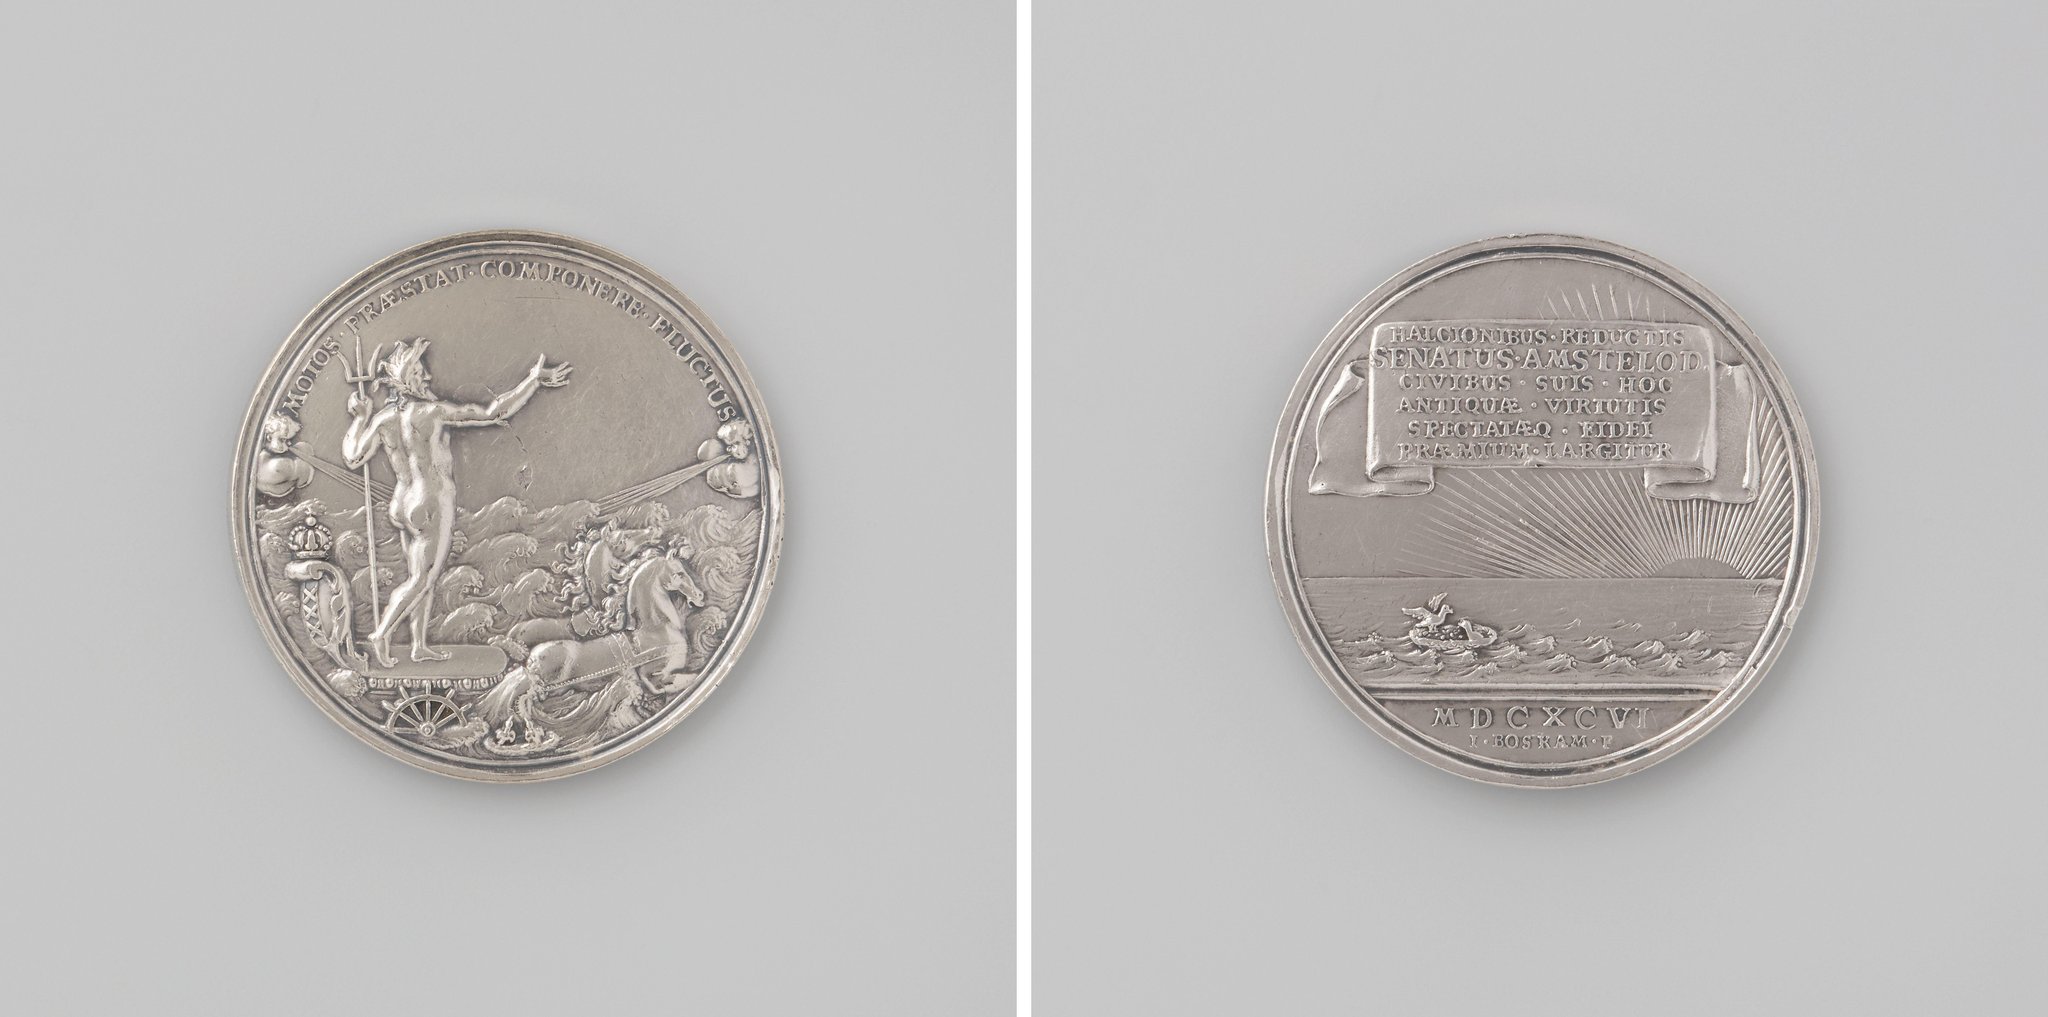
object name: history medal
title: Stillen van het aansprekersoproer te Amsterdam, penning aan de gewapende burgers vereerd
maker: jan boskam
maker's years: 1687-1708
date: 1696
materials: silver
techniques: striking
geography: nijmegen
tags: amsterdam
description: Zilveren penning. Voorzijde: Neptunus met drietand staande op zijn wagen in een woelige zee straft vertoornd de losgelaten stormwinden, op voorgrond twee vogels die uit nest dreigen te vallen binnen omschrift. Keerzijde: twee vogels in nest op kalme zee, terwijl zon opkomt onder wimpel met opschrift; afsnede: jaartal.